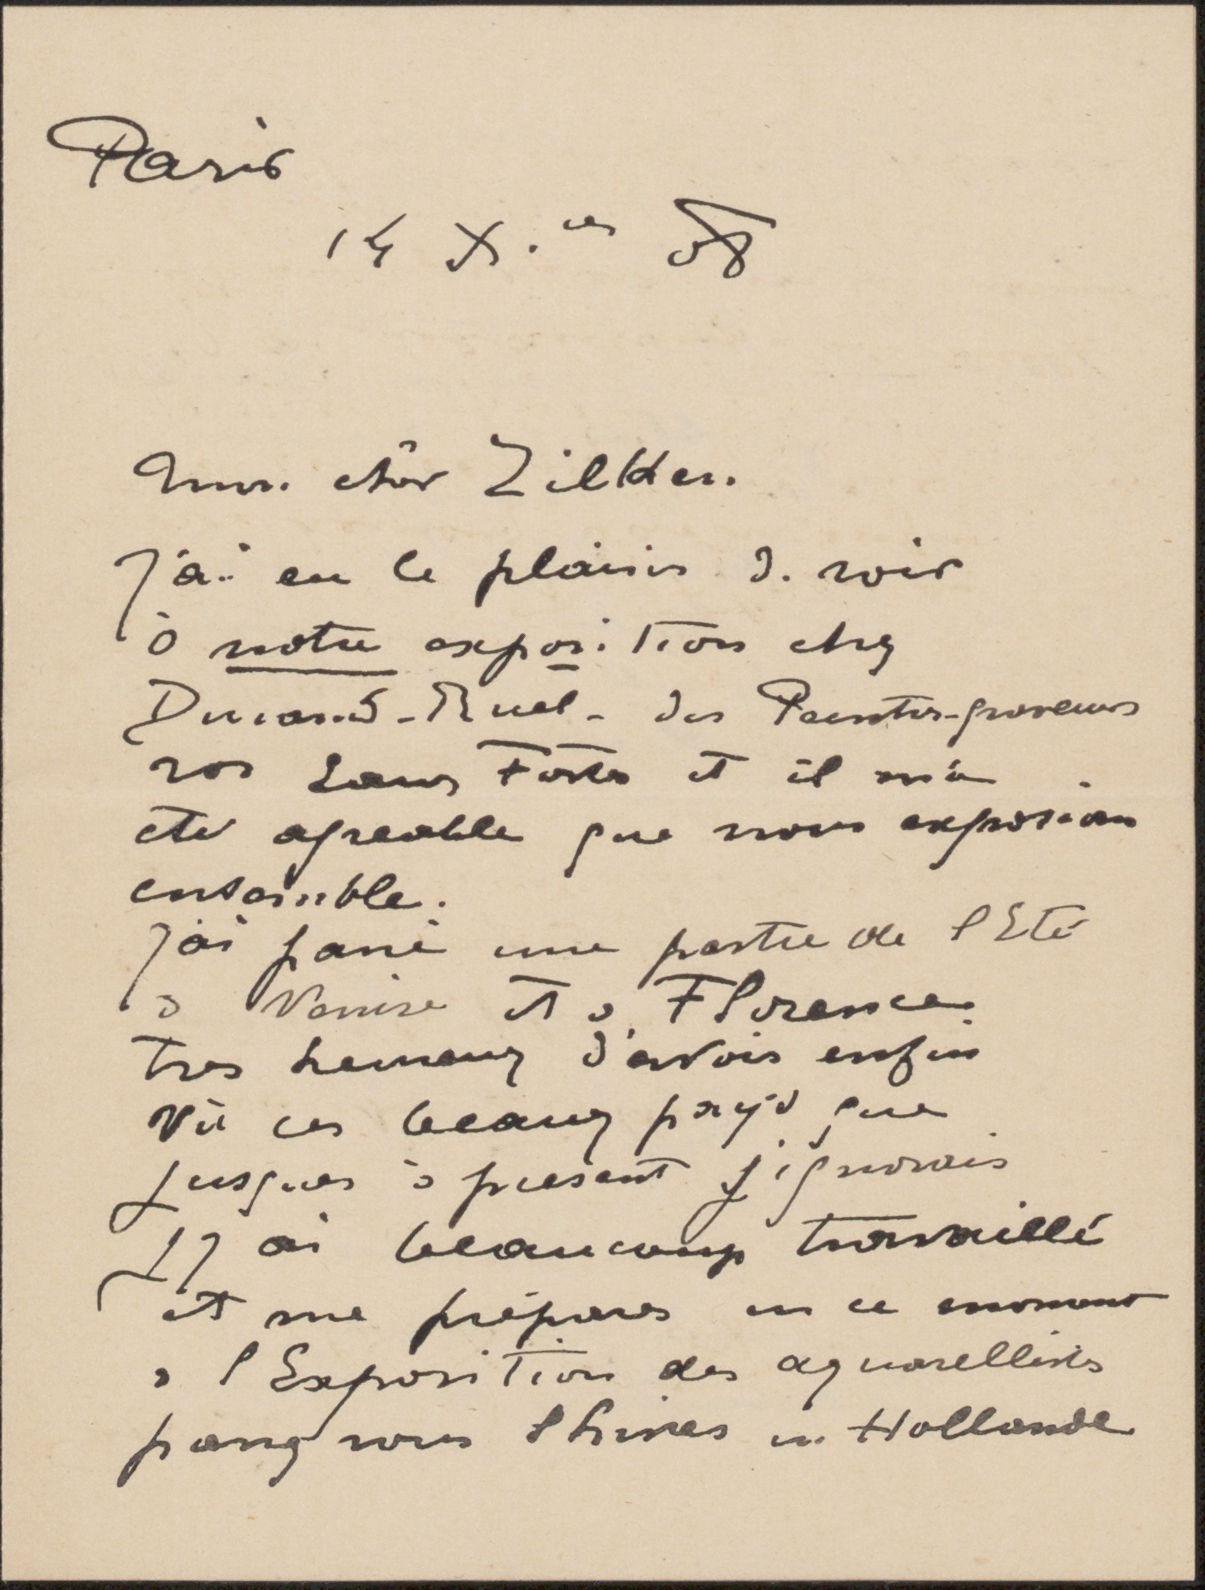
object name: letter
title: Brief aan Philip Zilcken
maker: henri pierre paillard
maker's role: painter, print maker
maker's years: 1844-1912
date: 1908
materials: ink, paper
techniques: pen, writing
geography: paris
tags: the hague, painter, draughtsman, philip zilcken, drawing, the graphic arts, exhibition ~ art, printed matter, holland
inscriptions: collector's mark: ‘RPK’